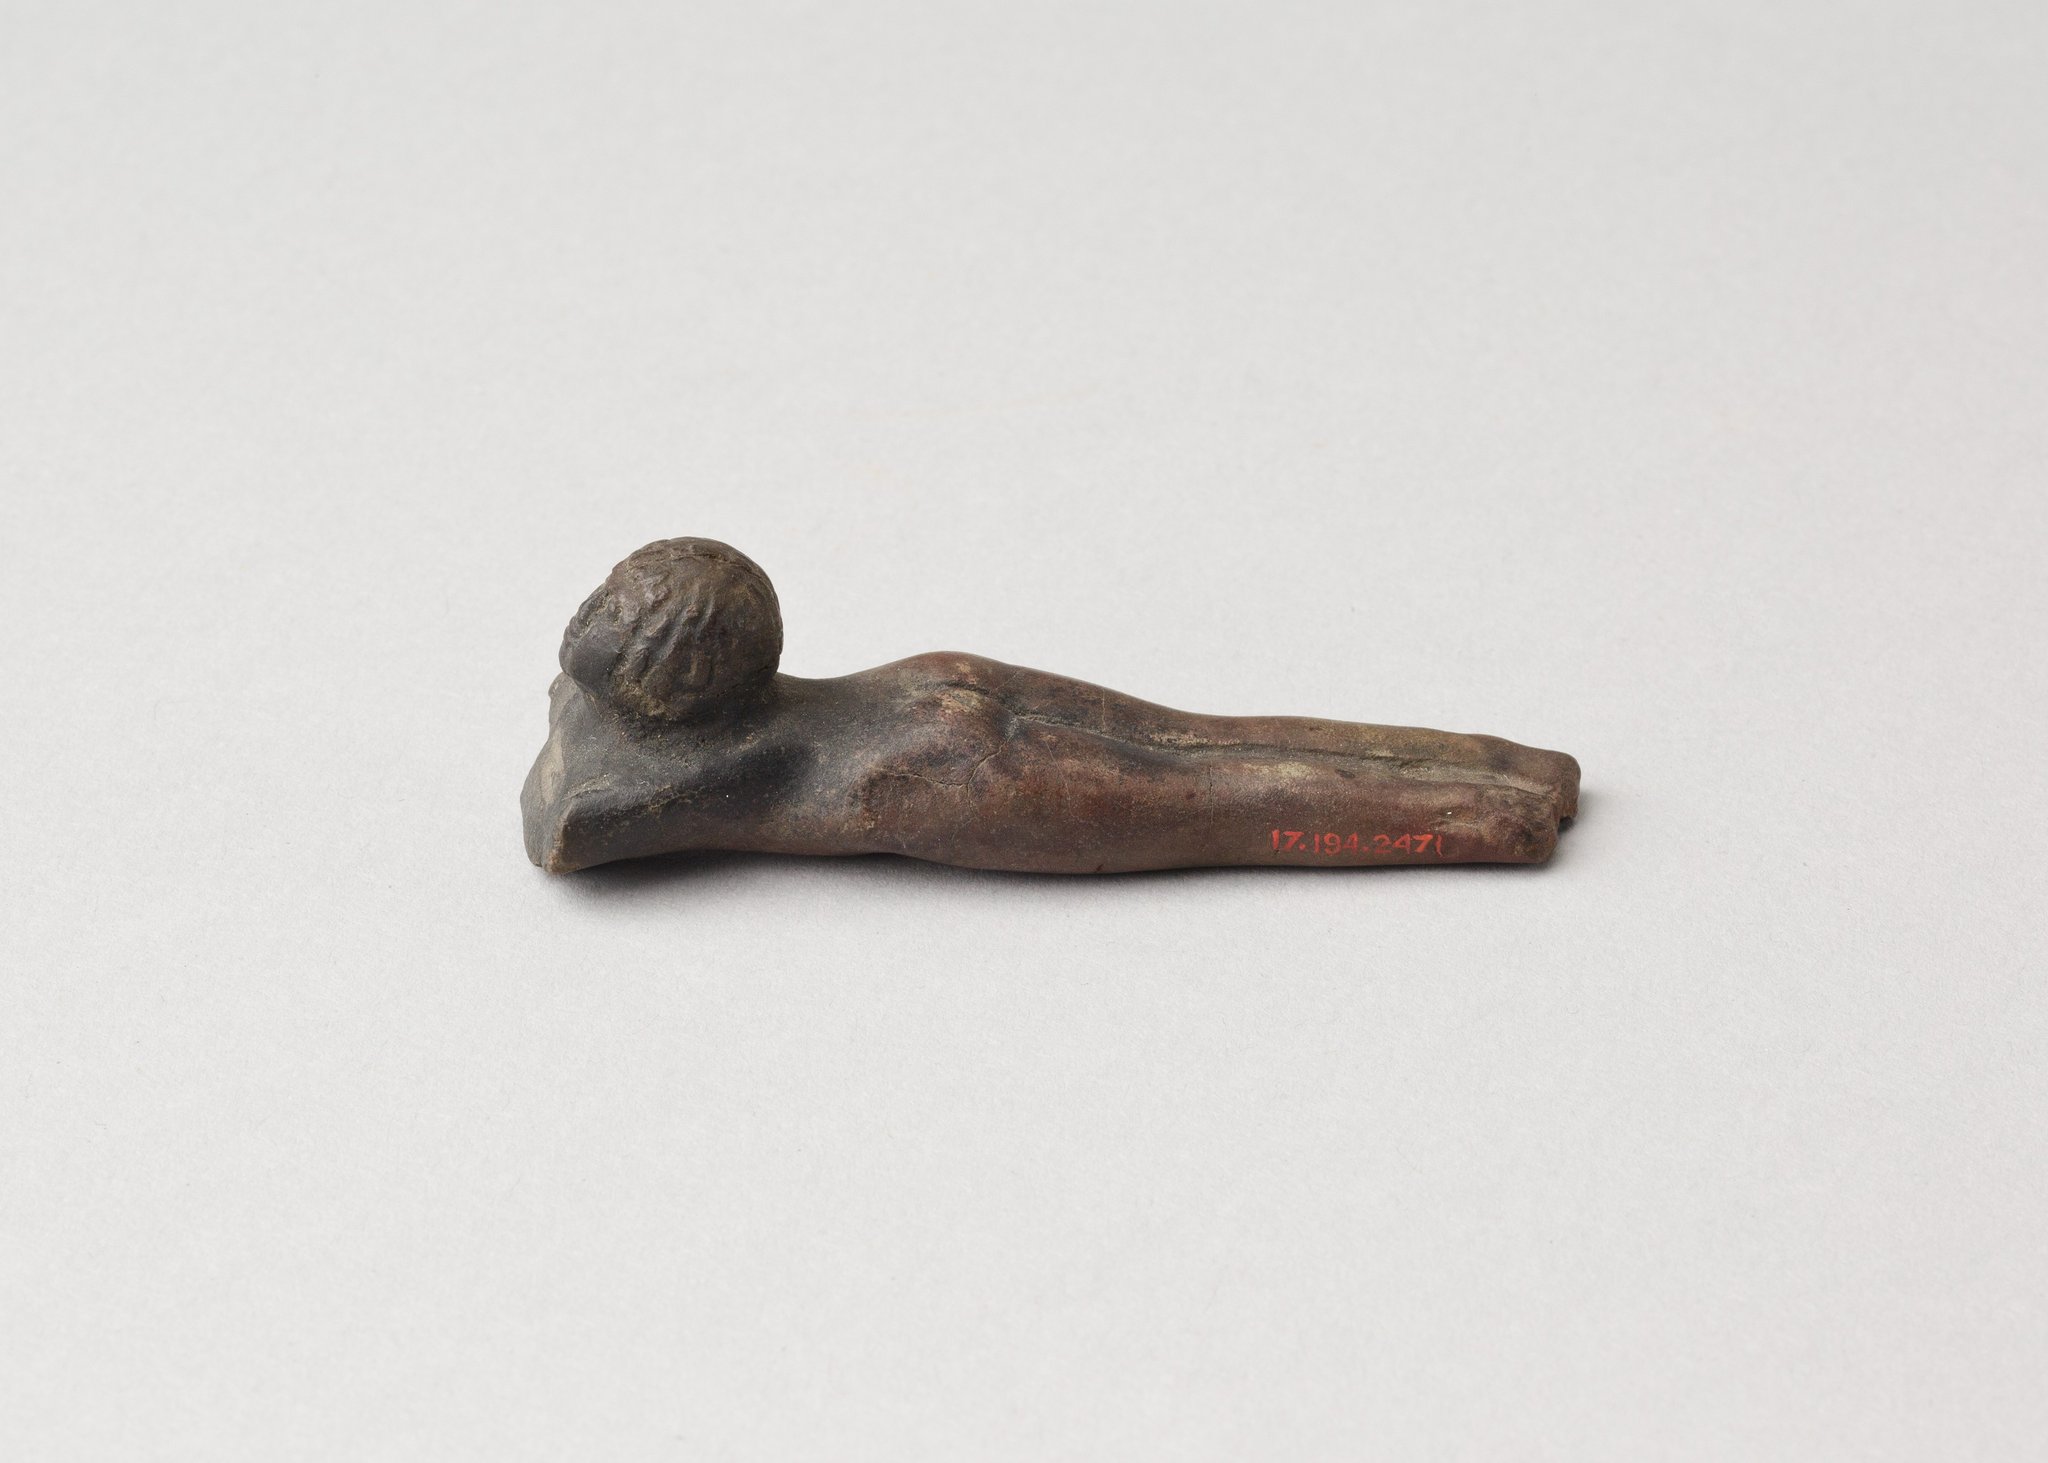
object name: cosmetic spoon, swimming girl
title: Handle from a cosmetic spoon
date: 1070-664 BCE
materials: clay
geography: egypt